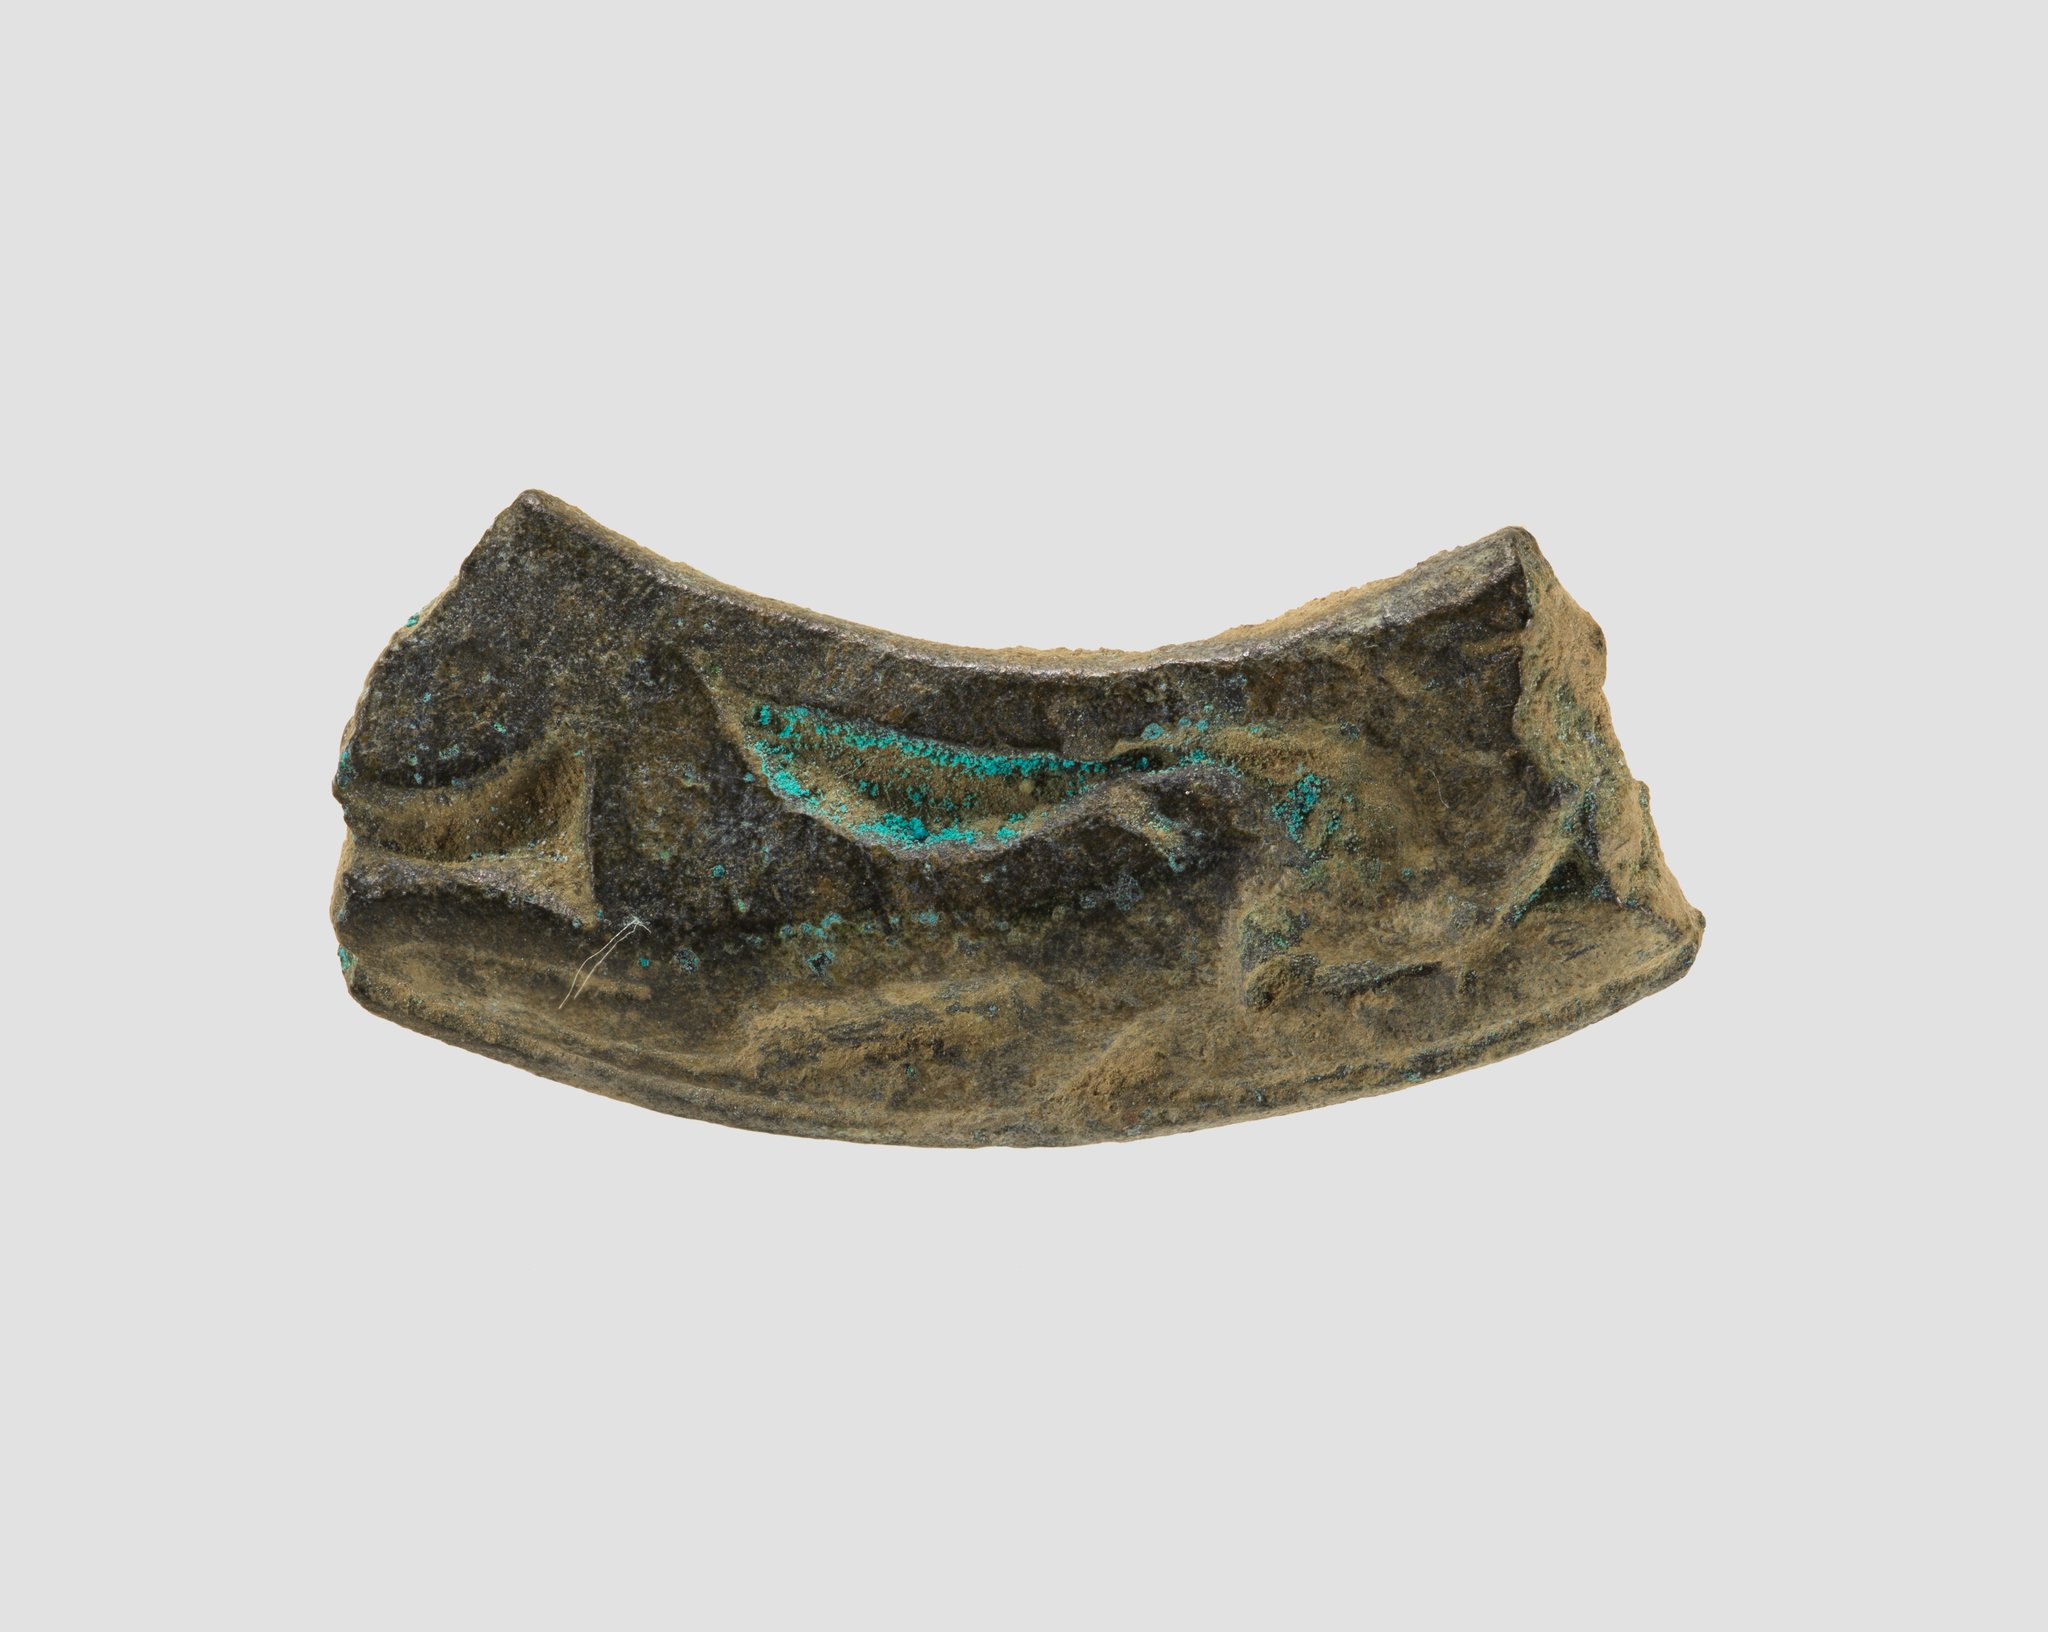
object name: ring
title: Ring fragment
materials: bronze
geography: levant